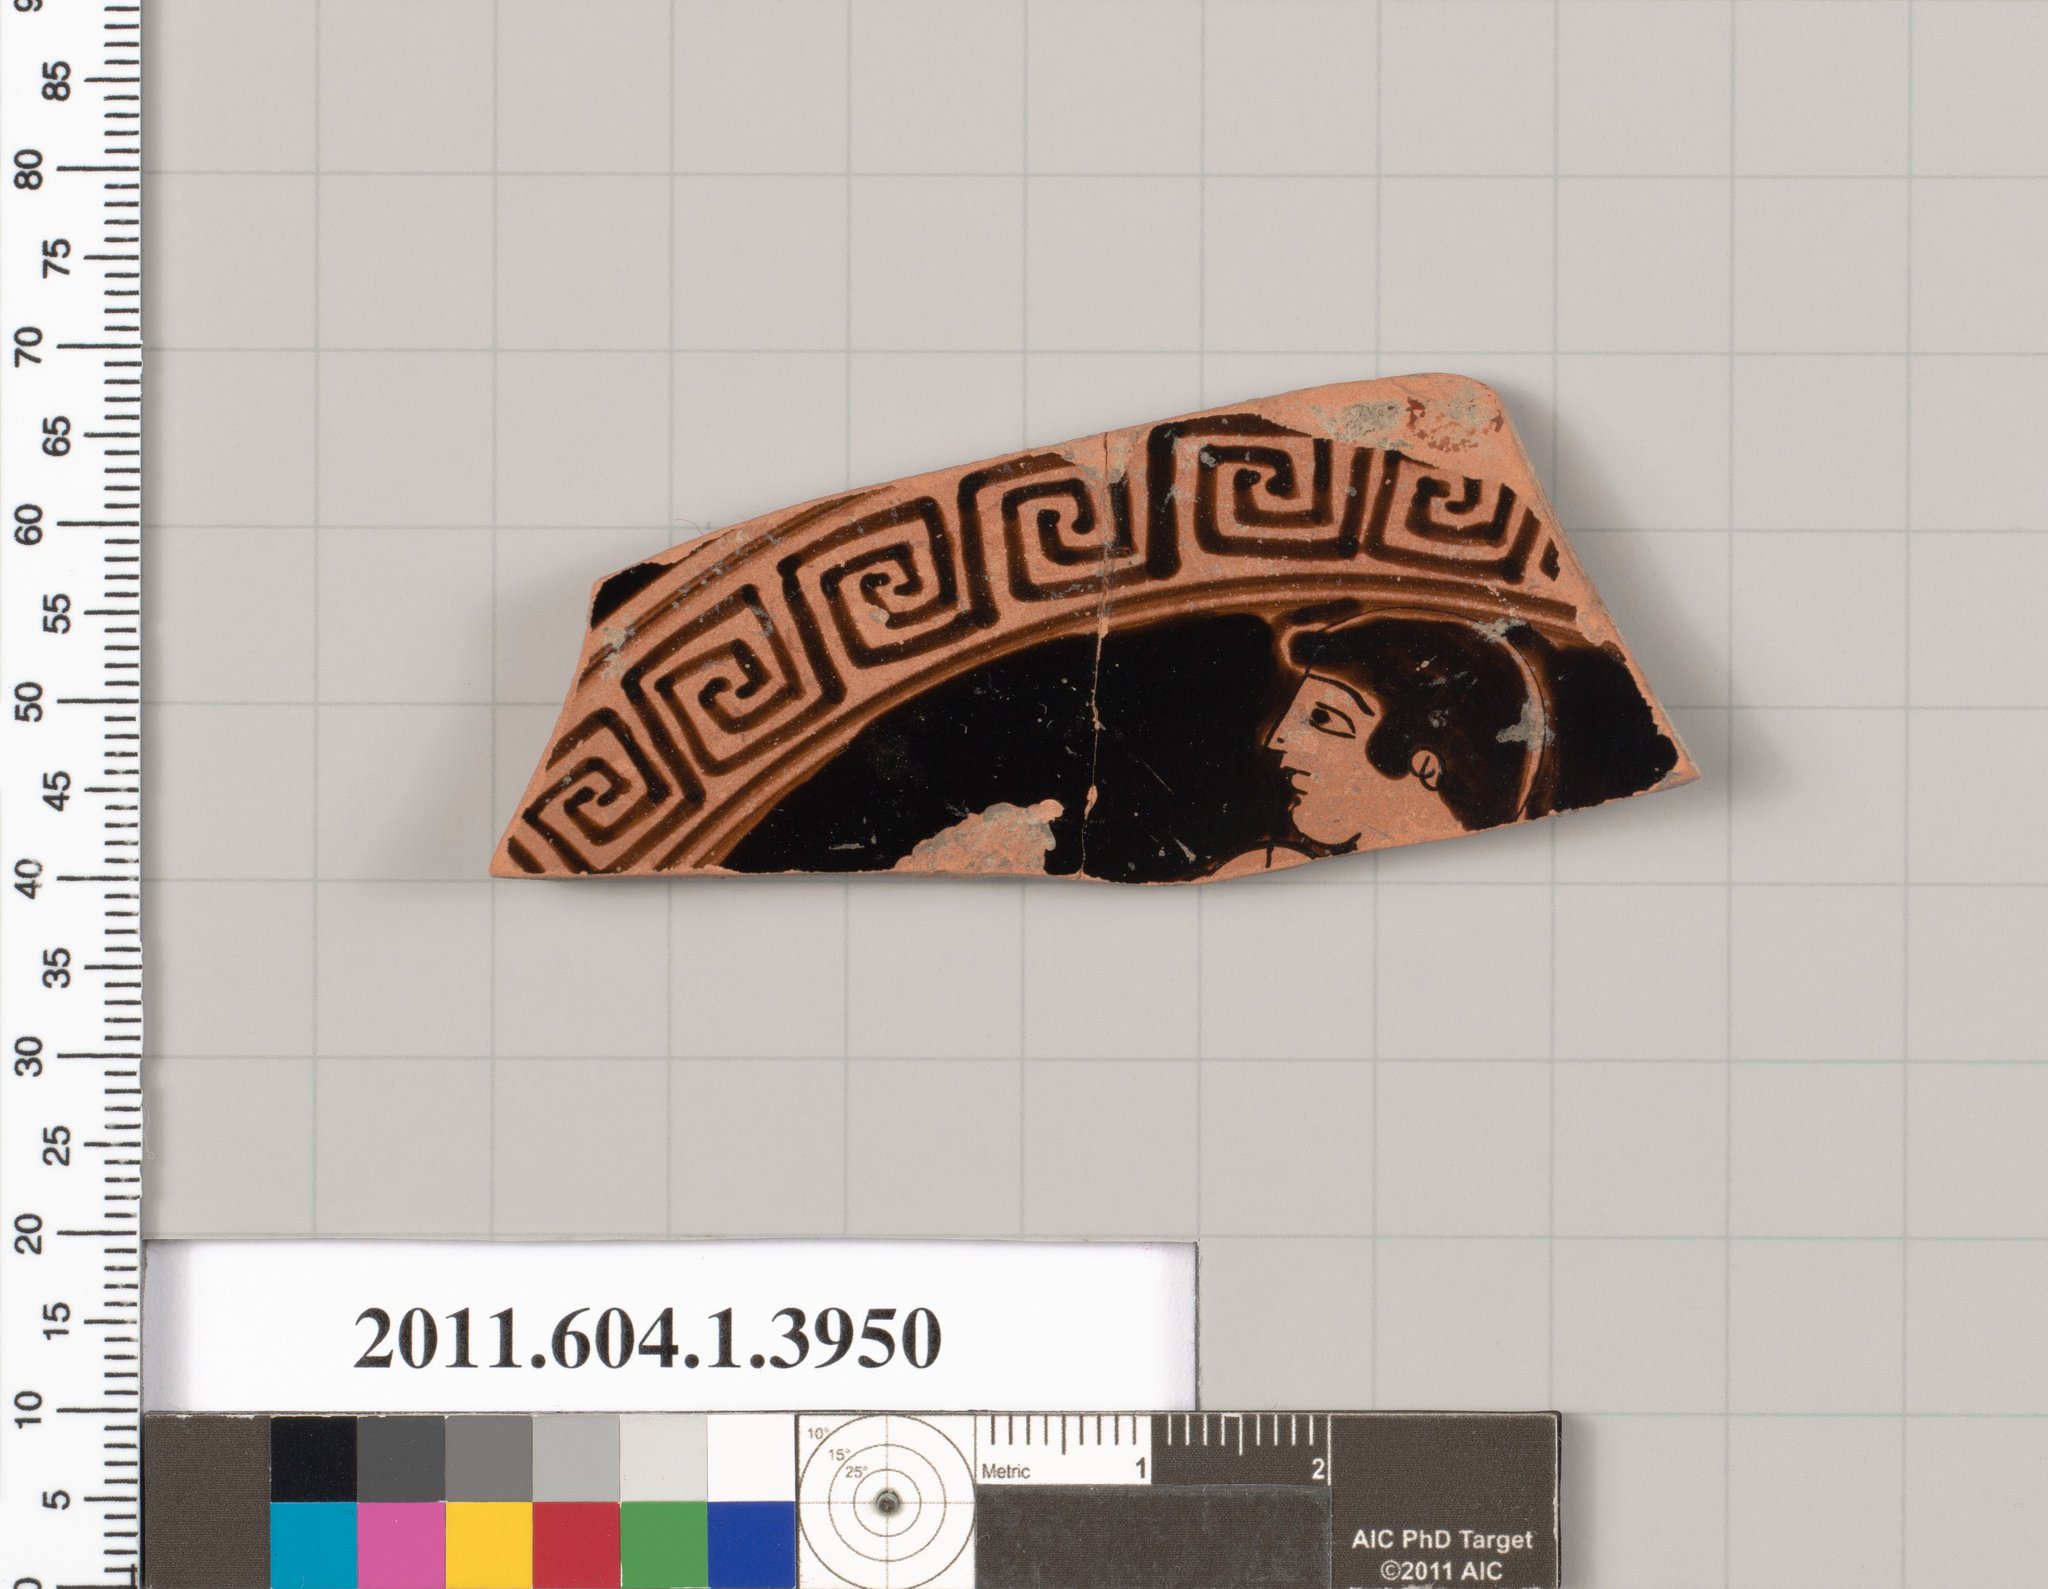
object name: kylix fragment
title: Terracotta fragment of a kylix (drinking cup)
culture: greek, attic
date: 475-451 BCE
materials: terracotta